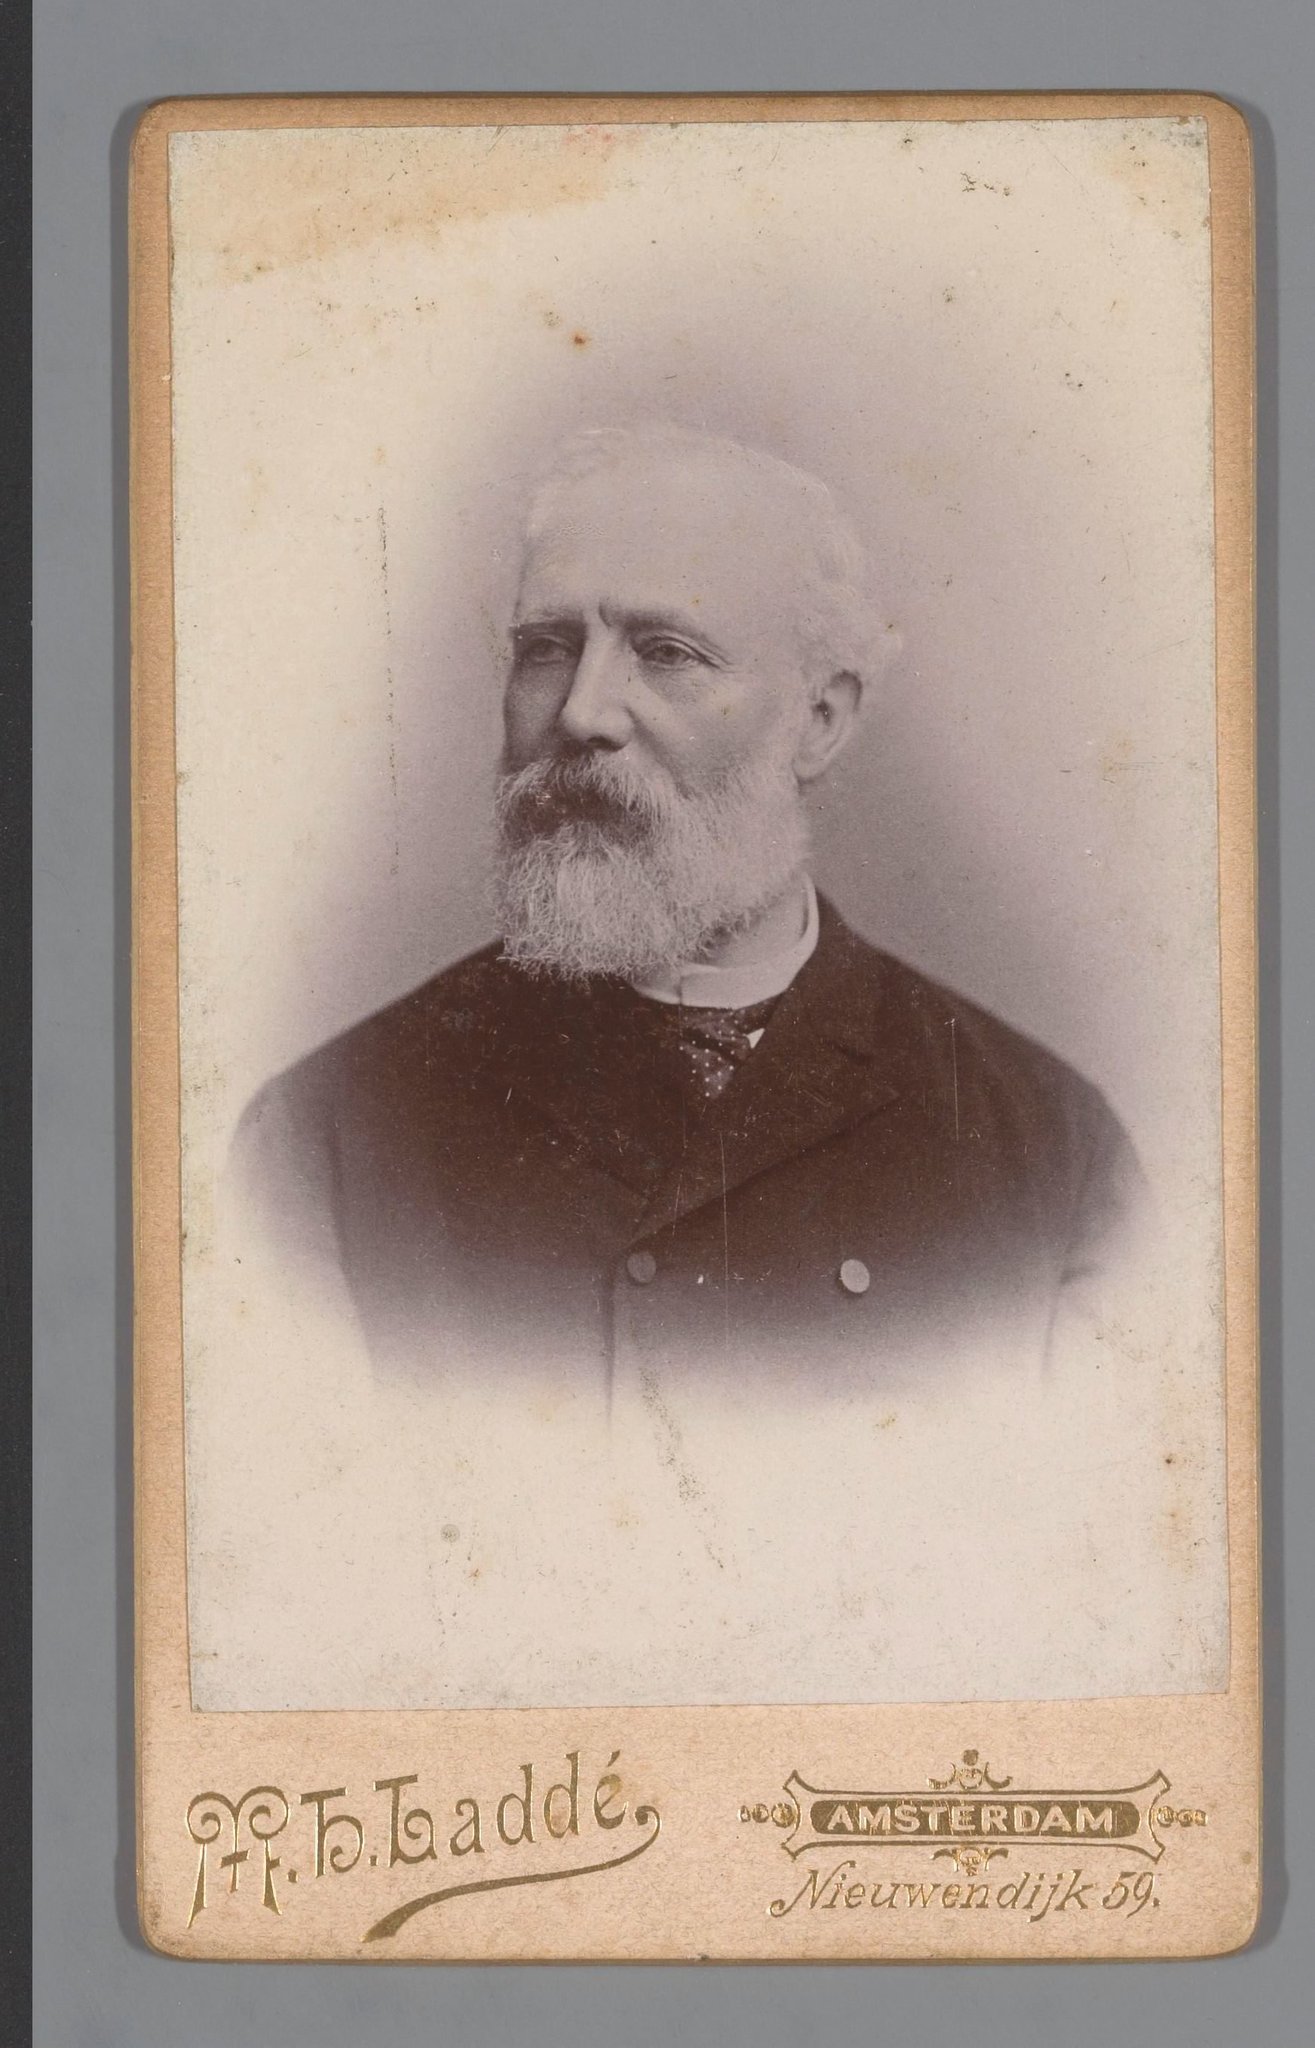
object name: carte de visite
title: Portret van een onbekende man met een baard en een snor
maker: machiel hendricus laddé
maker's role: fotograaf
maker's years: 1866-1932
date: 1892-1906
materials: cardboard, paper, photographic support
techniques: daylight paper print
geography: amsterdam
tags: adult man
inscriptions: name: ‘M.h. Laddé Amsterdam Nieuwendijk 59.’, name: ‘Pragter & Lojda, Berlin.’, inscription: ‘Photographie Artistique M.H. Laddé Nieuwendijk 59 boven de Firma Merkelbach & co. Amsterdam Het Cliche wordt voor verdere bestellingen bewaard.’